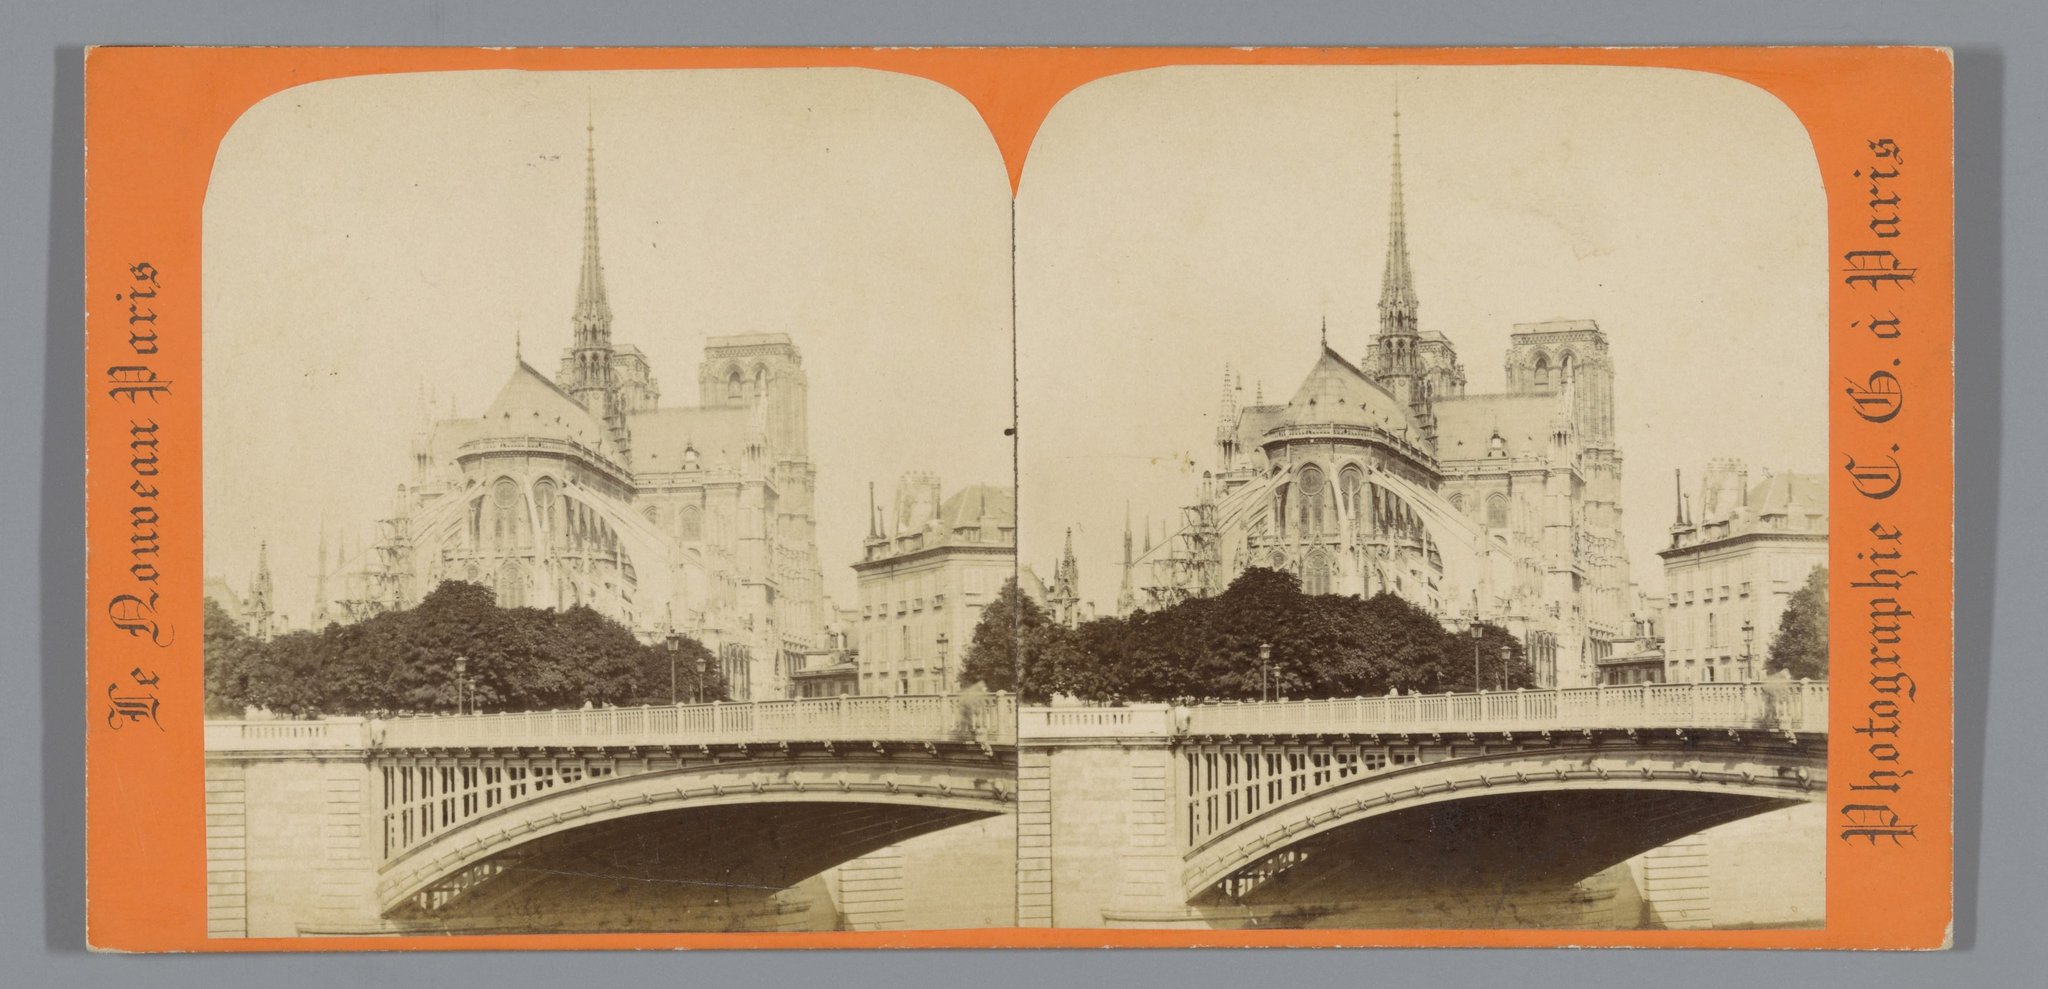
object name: stereograph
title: Le Nouveau Paris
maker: charles gérard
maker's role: fotograaf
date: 1860-1870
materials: cardboard, photographic support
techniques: albumen print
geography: paris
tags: notre-dame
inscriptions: inscription: ‘Photographie C. G. à Paris.’, inscription: ‘Notre Dame’